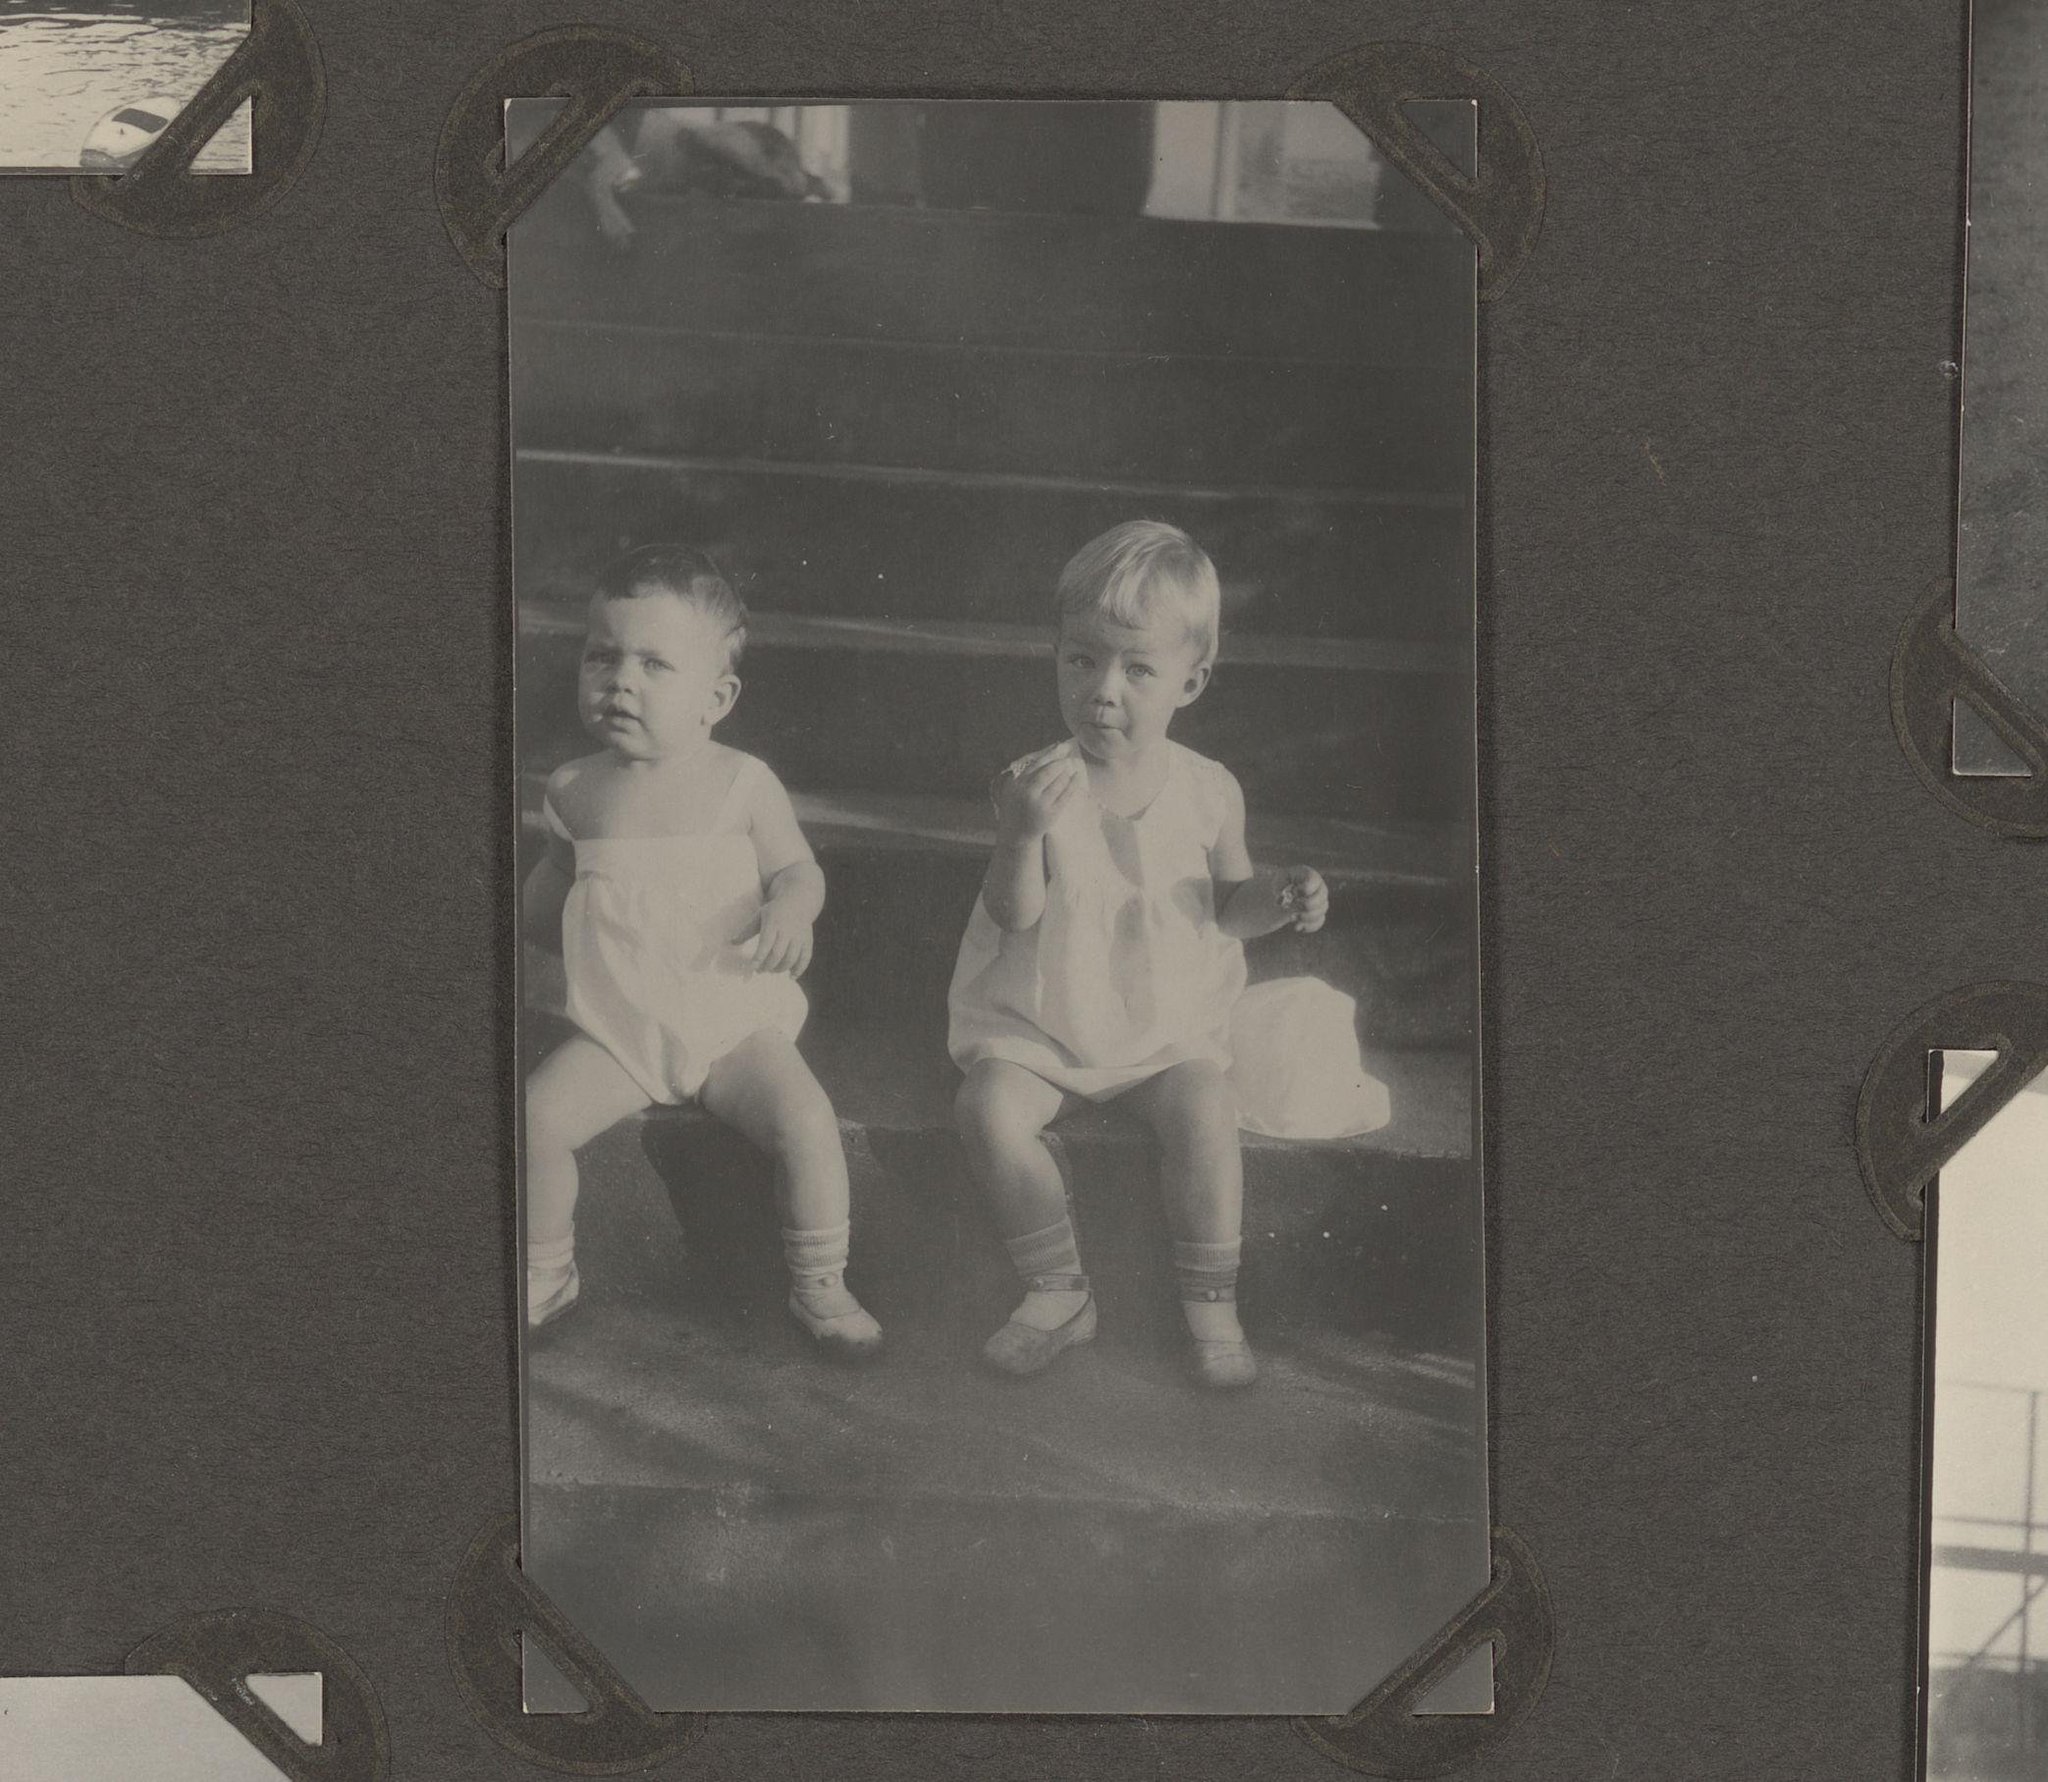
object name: photograph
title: Familiefoto van de kinderen Jetten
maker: Anonymous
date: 1925-1927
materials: photographic support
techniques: photography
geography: suriname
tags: jetten, familie, moengo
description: Familiefoto van de kinderen Jetten met Surinaamse kinderjuffrouw. Foto op een bladzijde van een los albumblad. Onderdeel van het ensemble met foto's van de familie van ingenieur Jetten in de mijnbouwstad Moengo in Suriname.